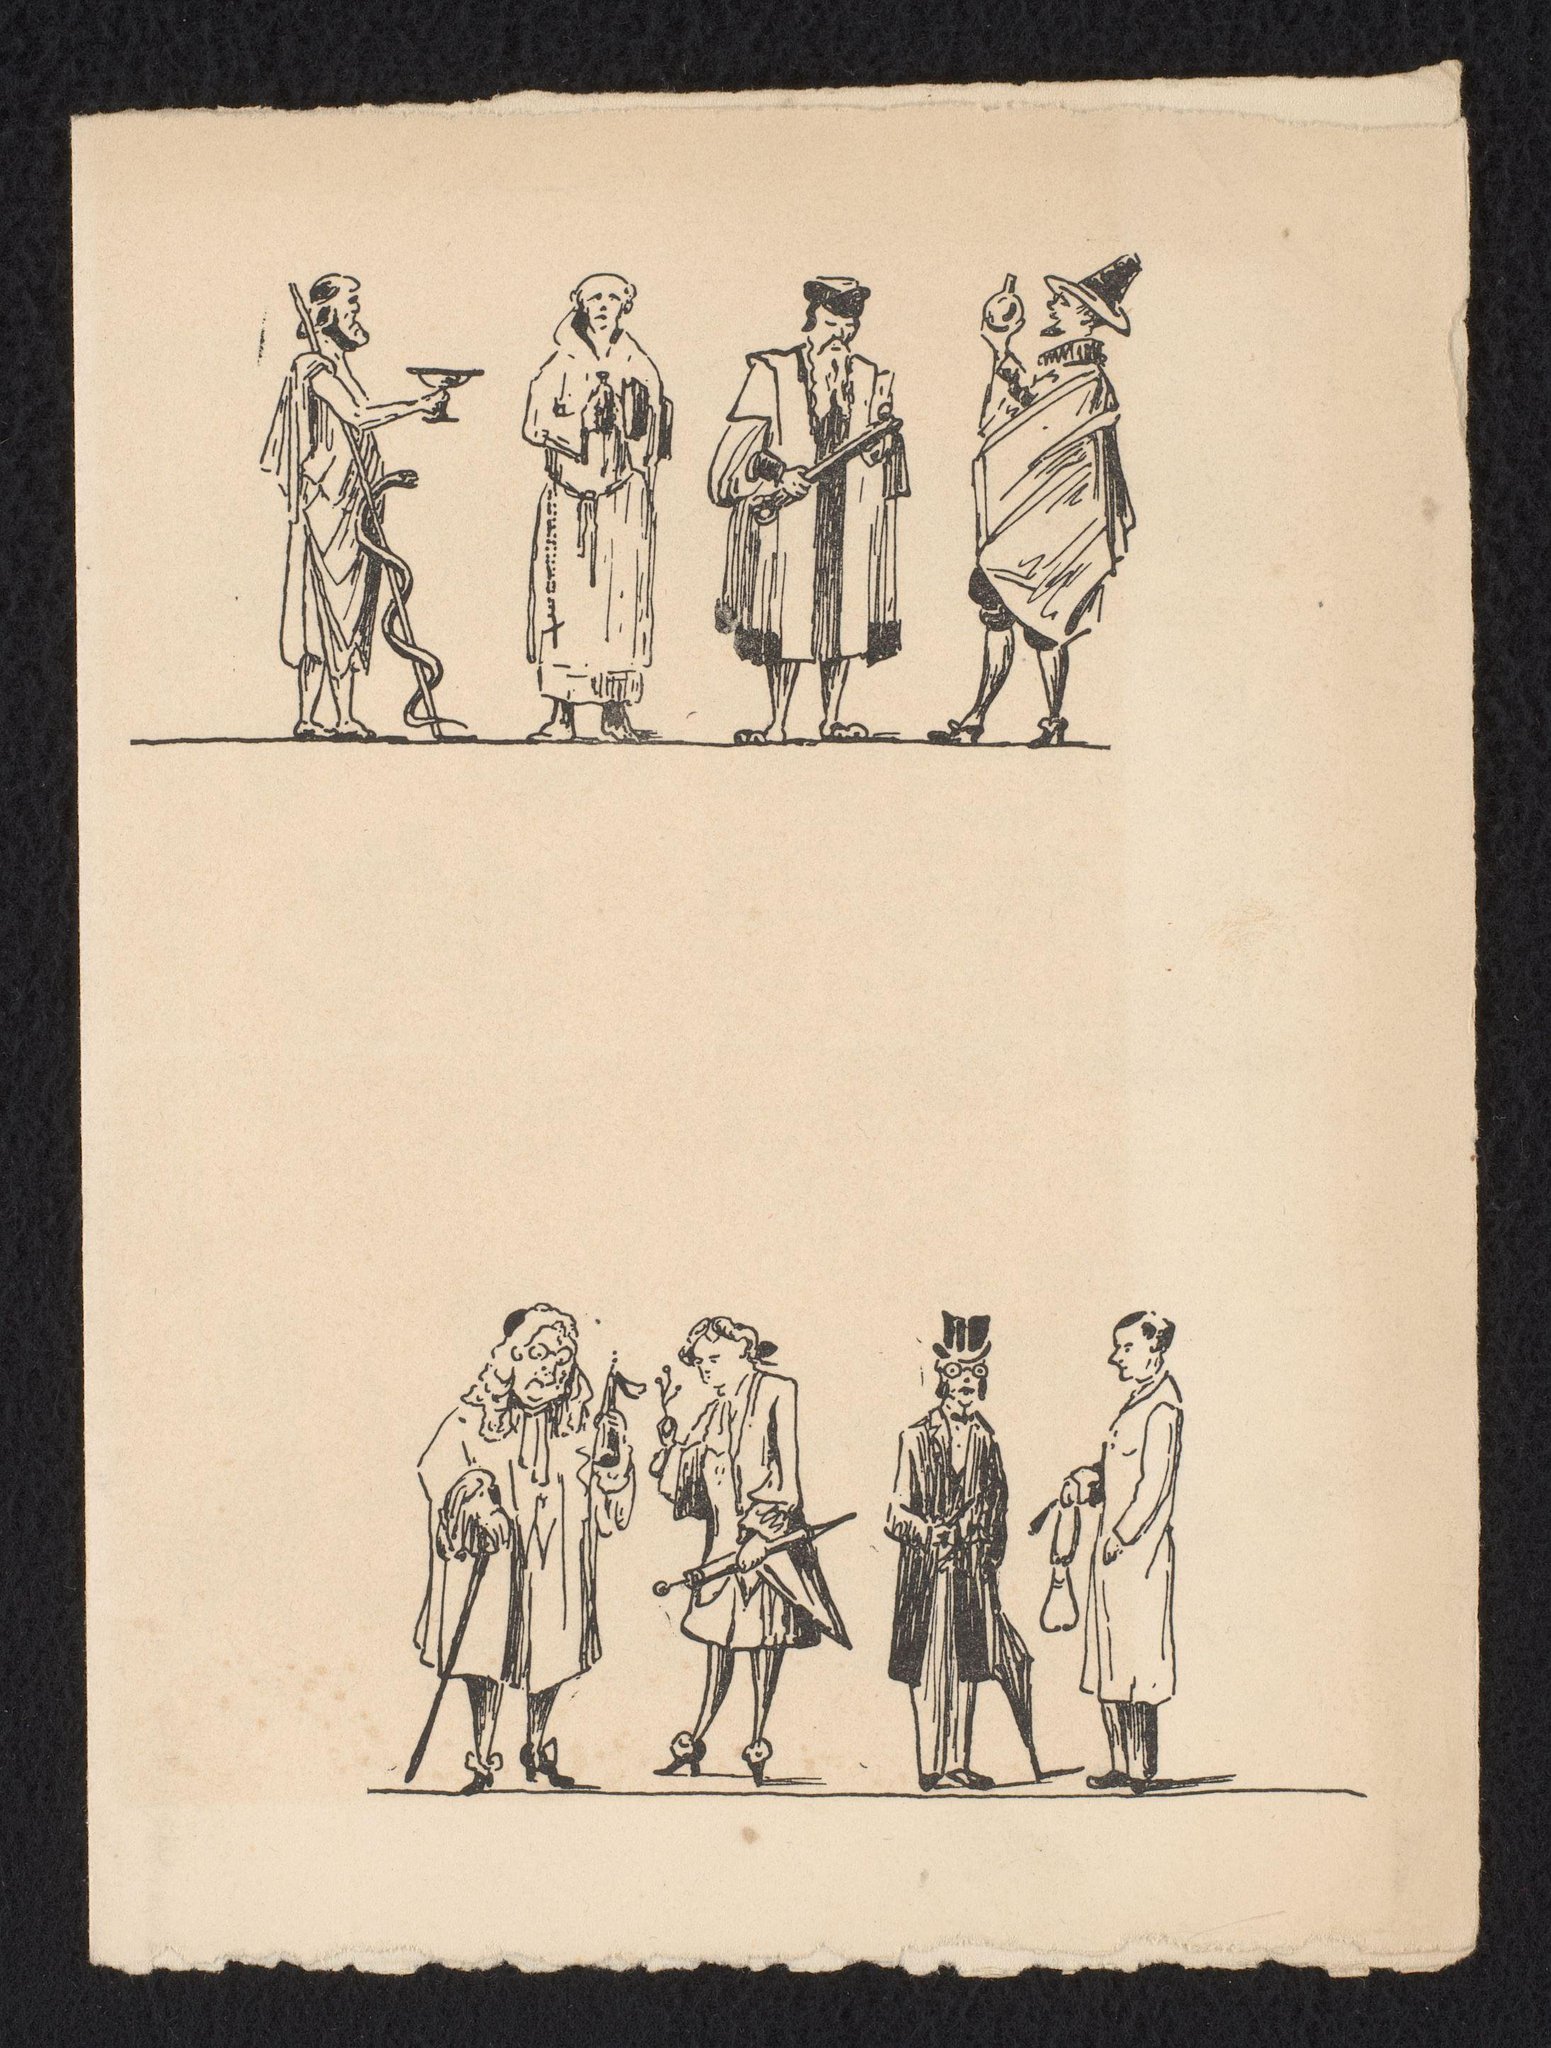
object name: menu, menukaart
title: Menukaart van het diner bij de Internationale Tentoonstelling op Hygienisch Gebied in Amsterdam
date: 1921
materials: paper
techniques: printing block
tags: care of the body, hygiene, medical research, branches of medicine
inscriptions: collector's mark: Lugt 2233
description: Op de voorzijde twee rijen van vier figuren, elk betrokken bij wetenschap en ontwikkeling. Binnenin het menu, omringd door wetenschappelijke objecten en apparaten, en de bijeengestoken hoofden van drie mannen.